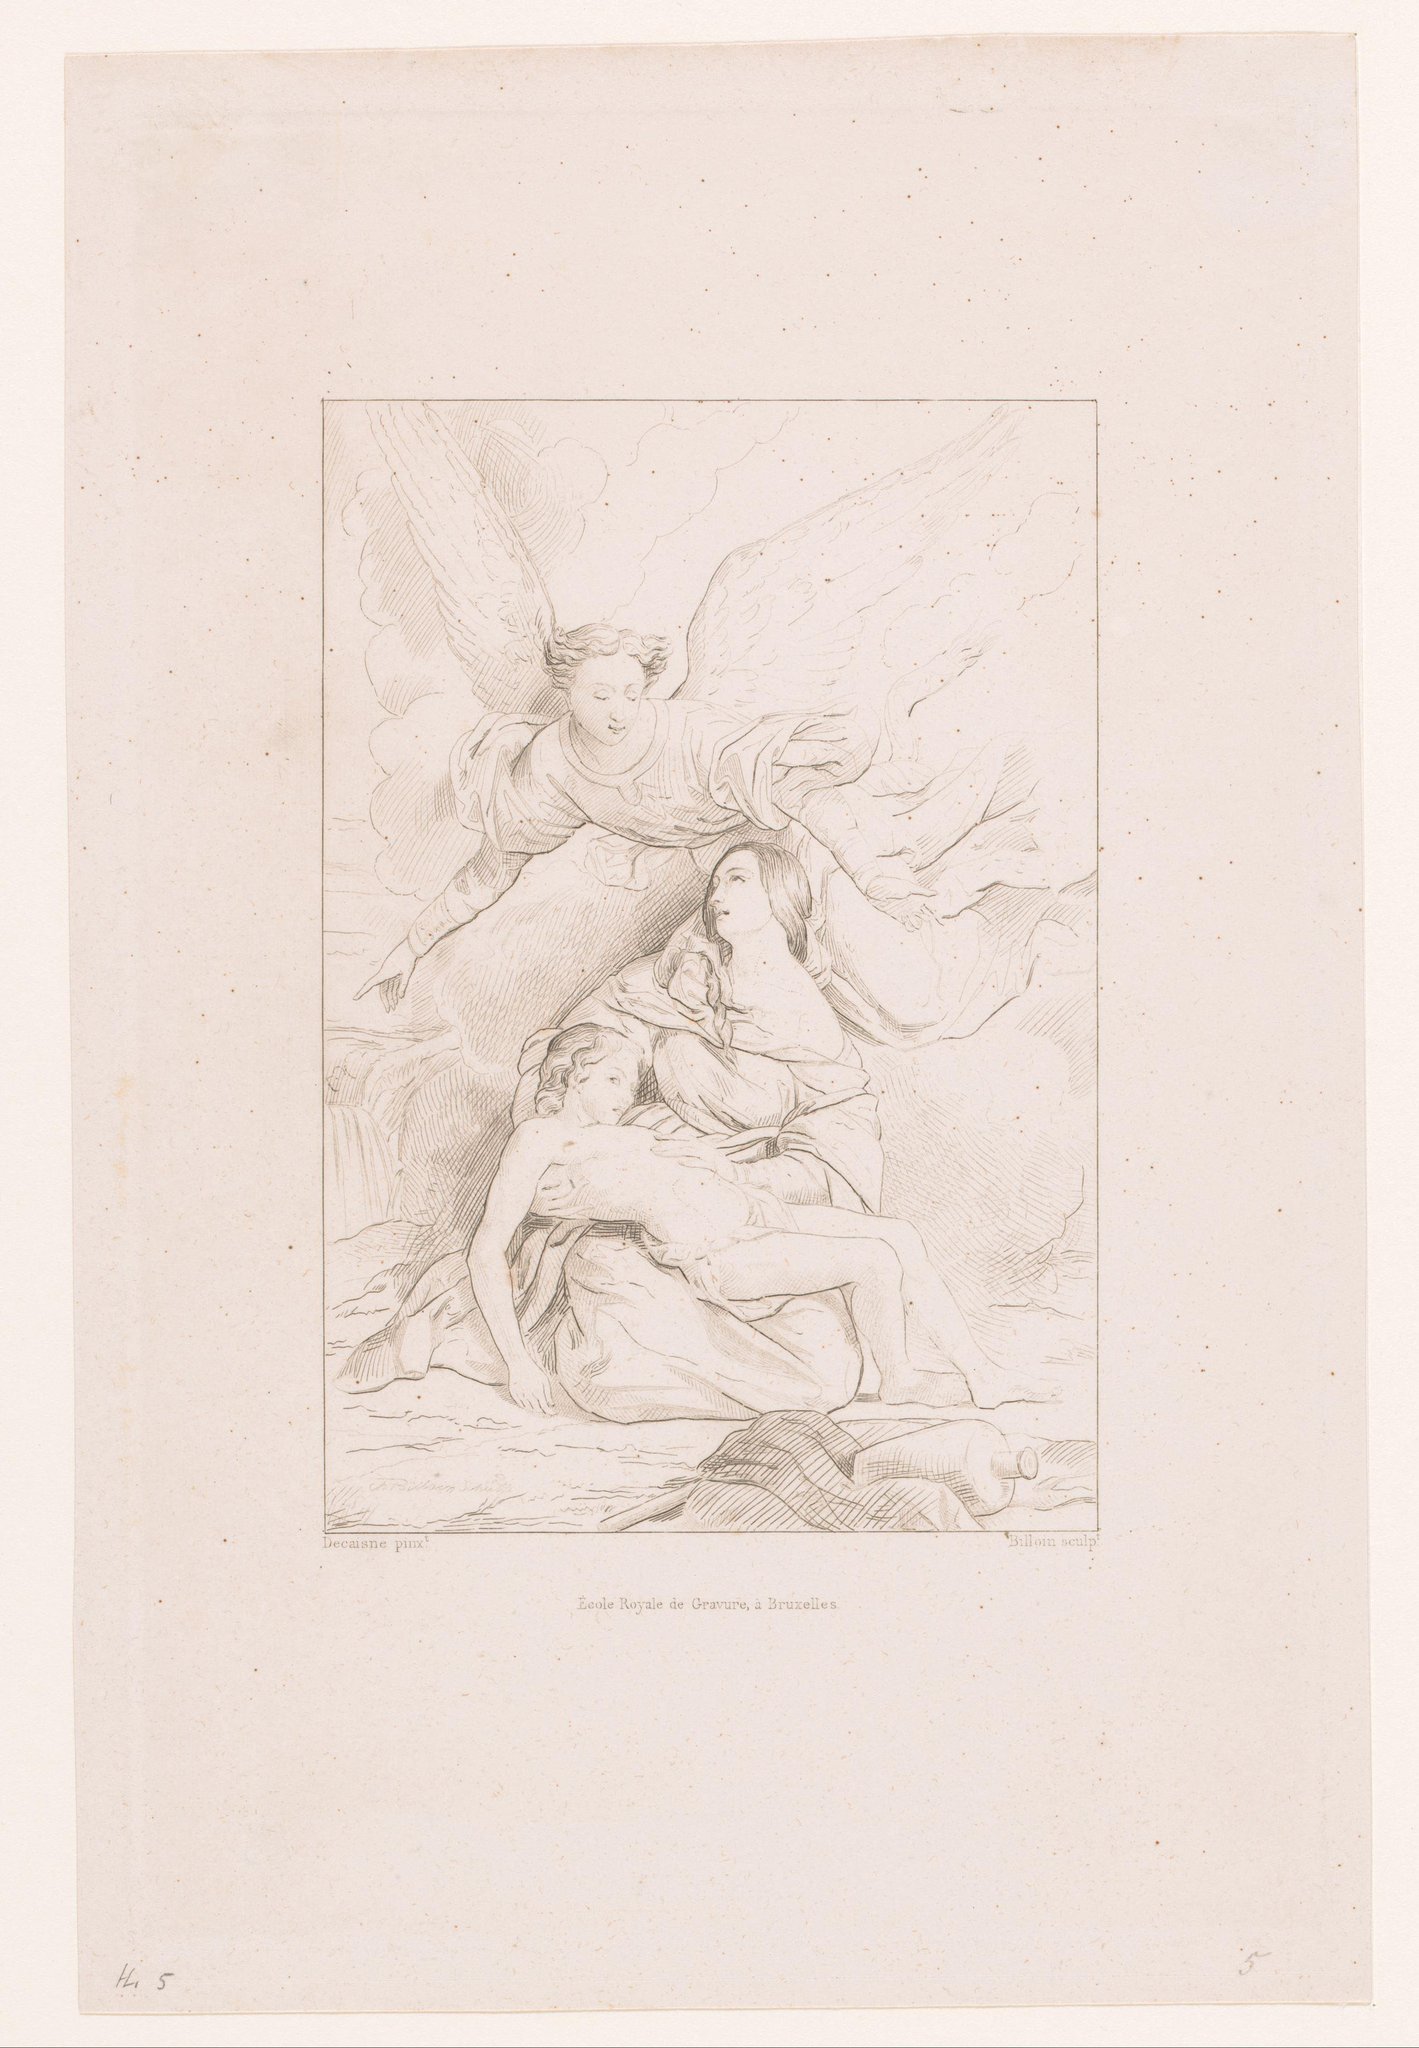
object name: print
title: Hagar en Ismaël in de woestijn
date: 1823-1869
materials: paper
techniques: etching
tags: an angel appears and reveals a well of water to hagar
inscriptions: collector's mark: Lugt 1485, collector's mark: Lugt 2228